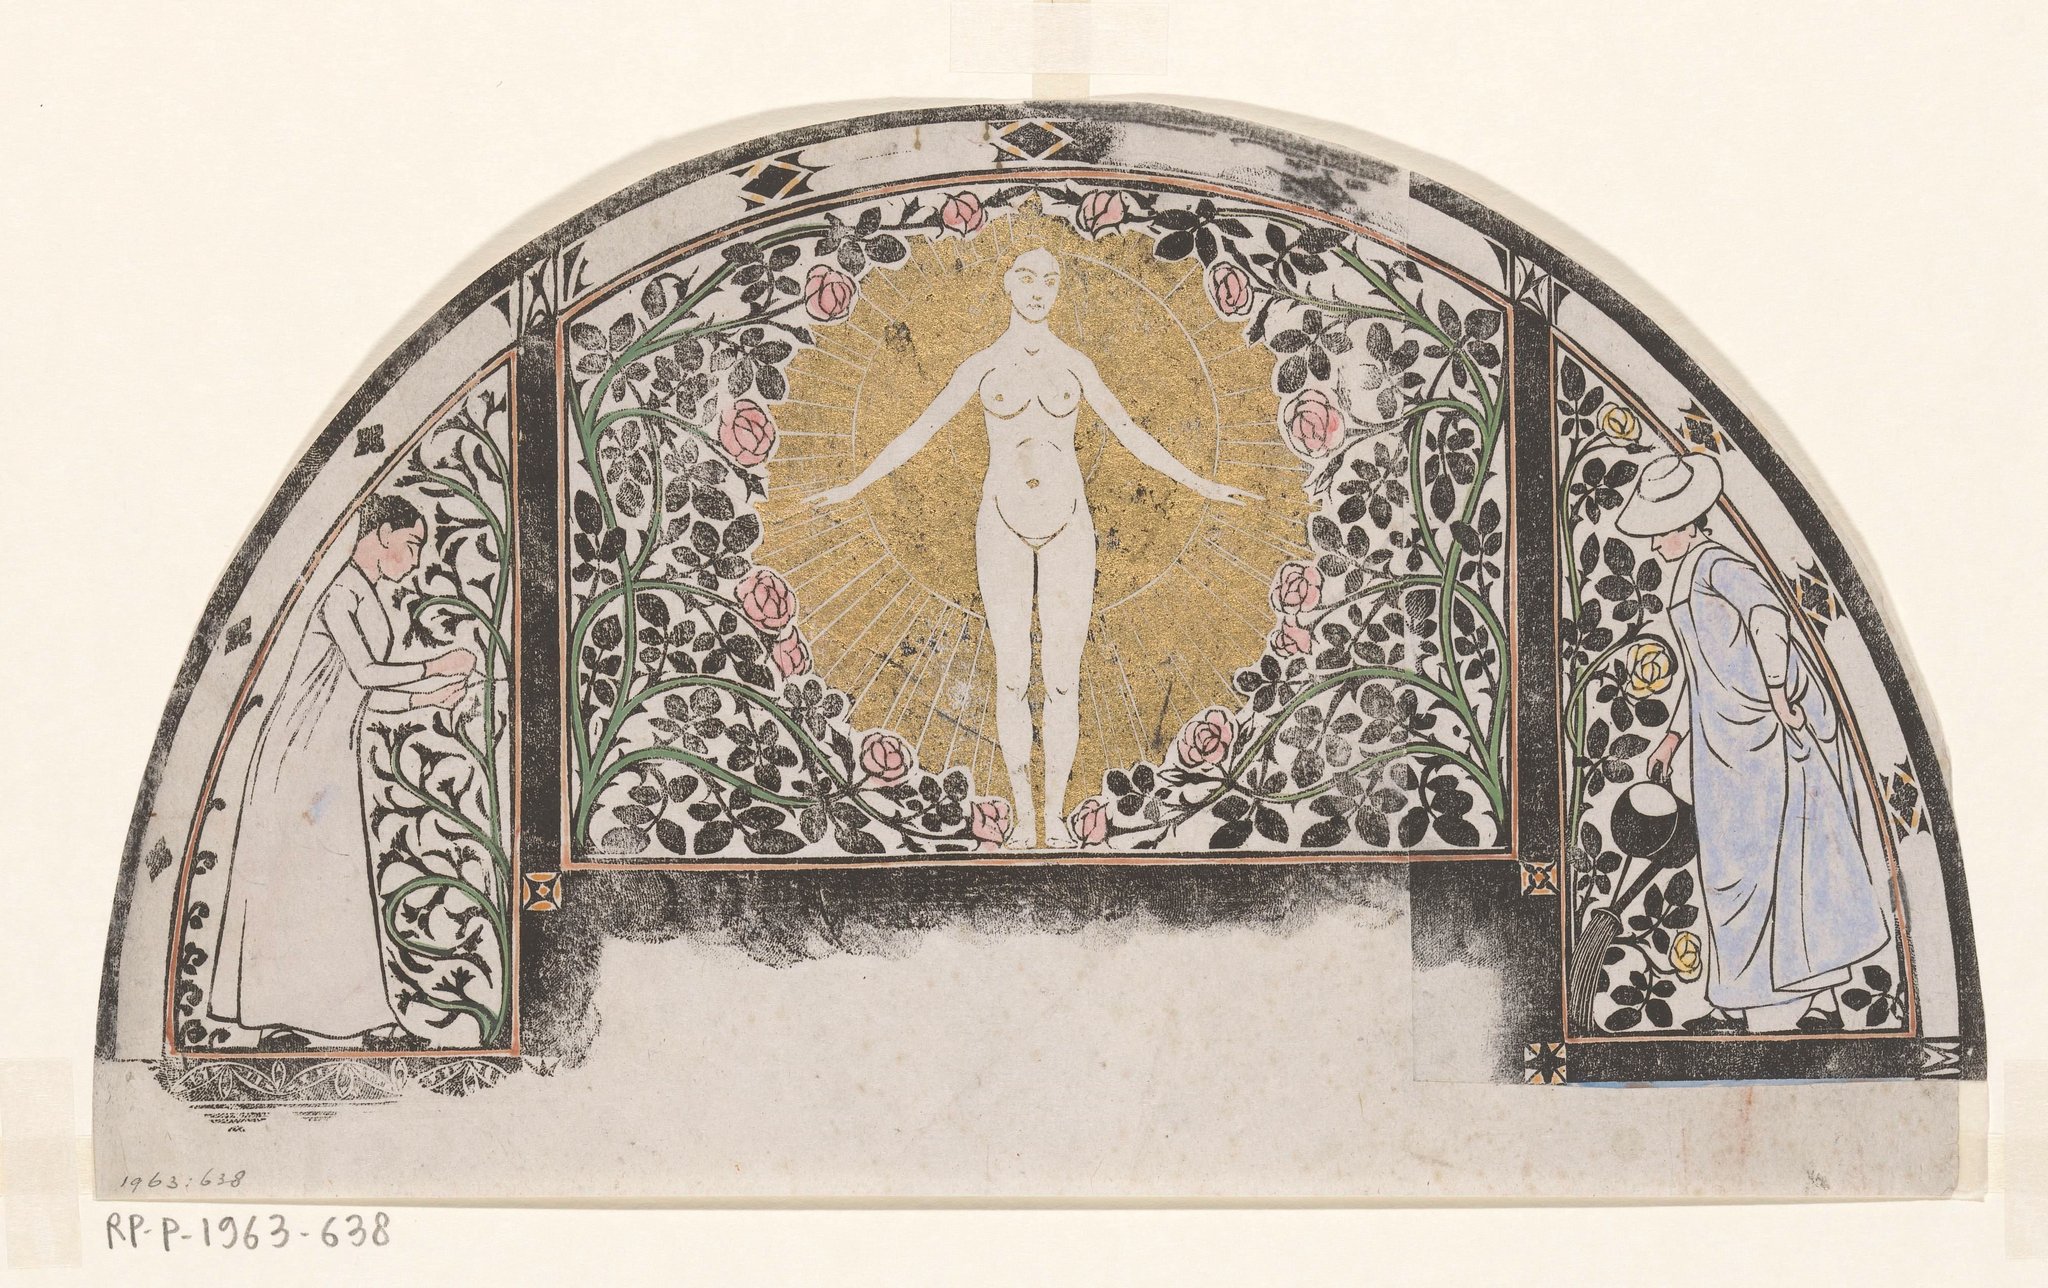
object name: calendar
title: Ontwerp voor de omlijsting van een kalender voor 1901 met vrouwen en bloemen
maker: gerrit willem dijsselhof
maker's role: designer, draughtsman, print maker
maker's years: 1866-1924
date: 1900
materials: chalk, paper, watercolor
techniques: hand coloring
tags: seasons of the year represented by scenes showing human activities, usually in a landscape, woman (showing herself) undressed, quasi-nude, gardening, flowers: rose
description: In het midden een staande, naakte vrouw met gespreide armen. Achter haar een stralende zon. Om haar heen groeien rozenstruiken. Links en rechts een vrouw die respectievelijk in de lente en zomer een rozenstruik verzorgt.